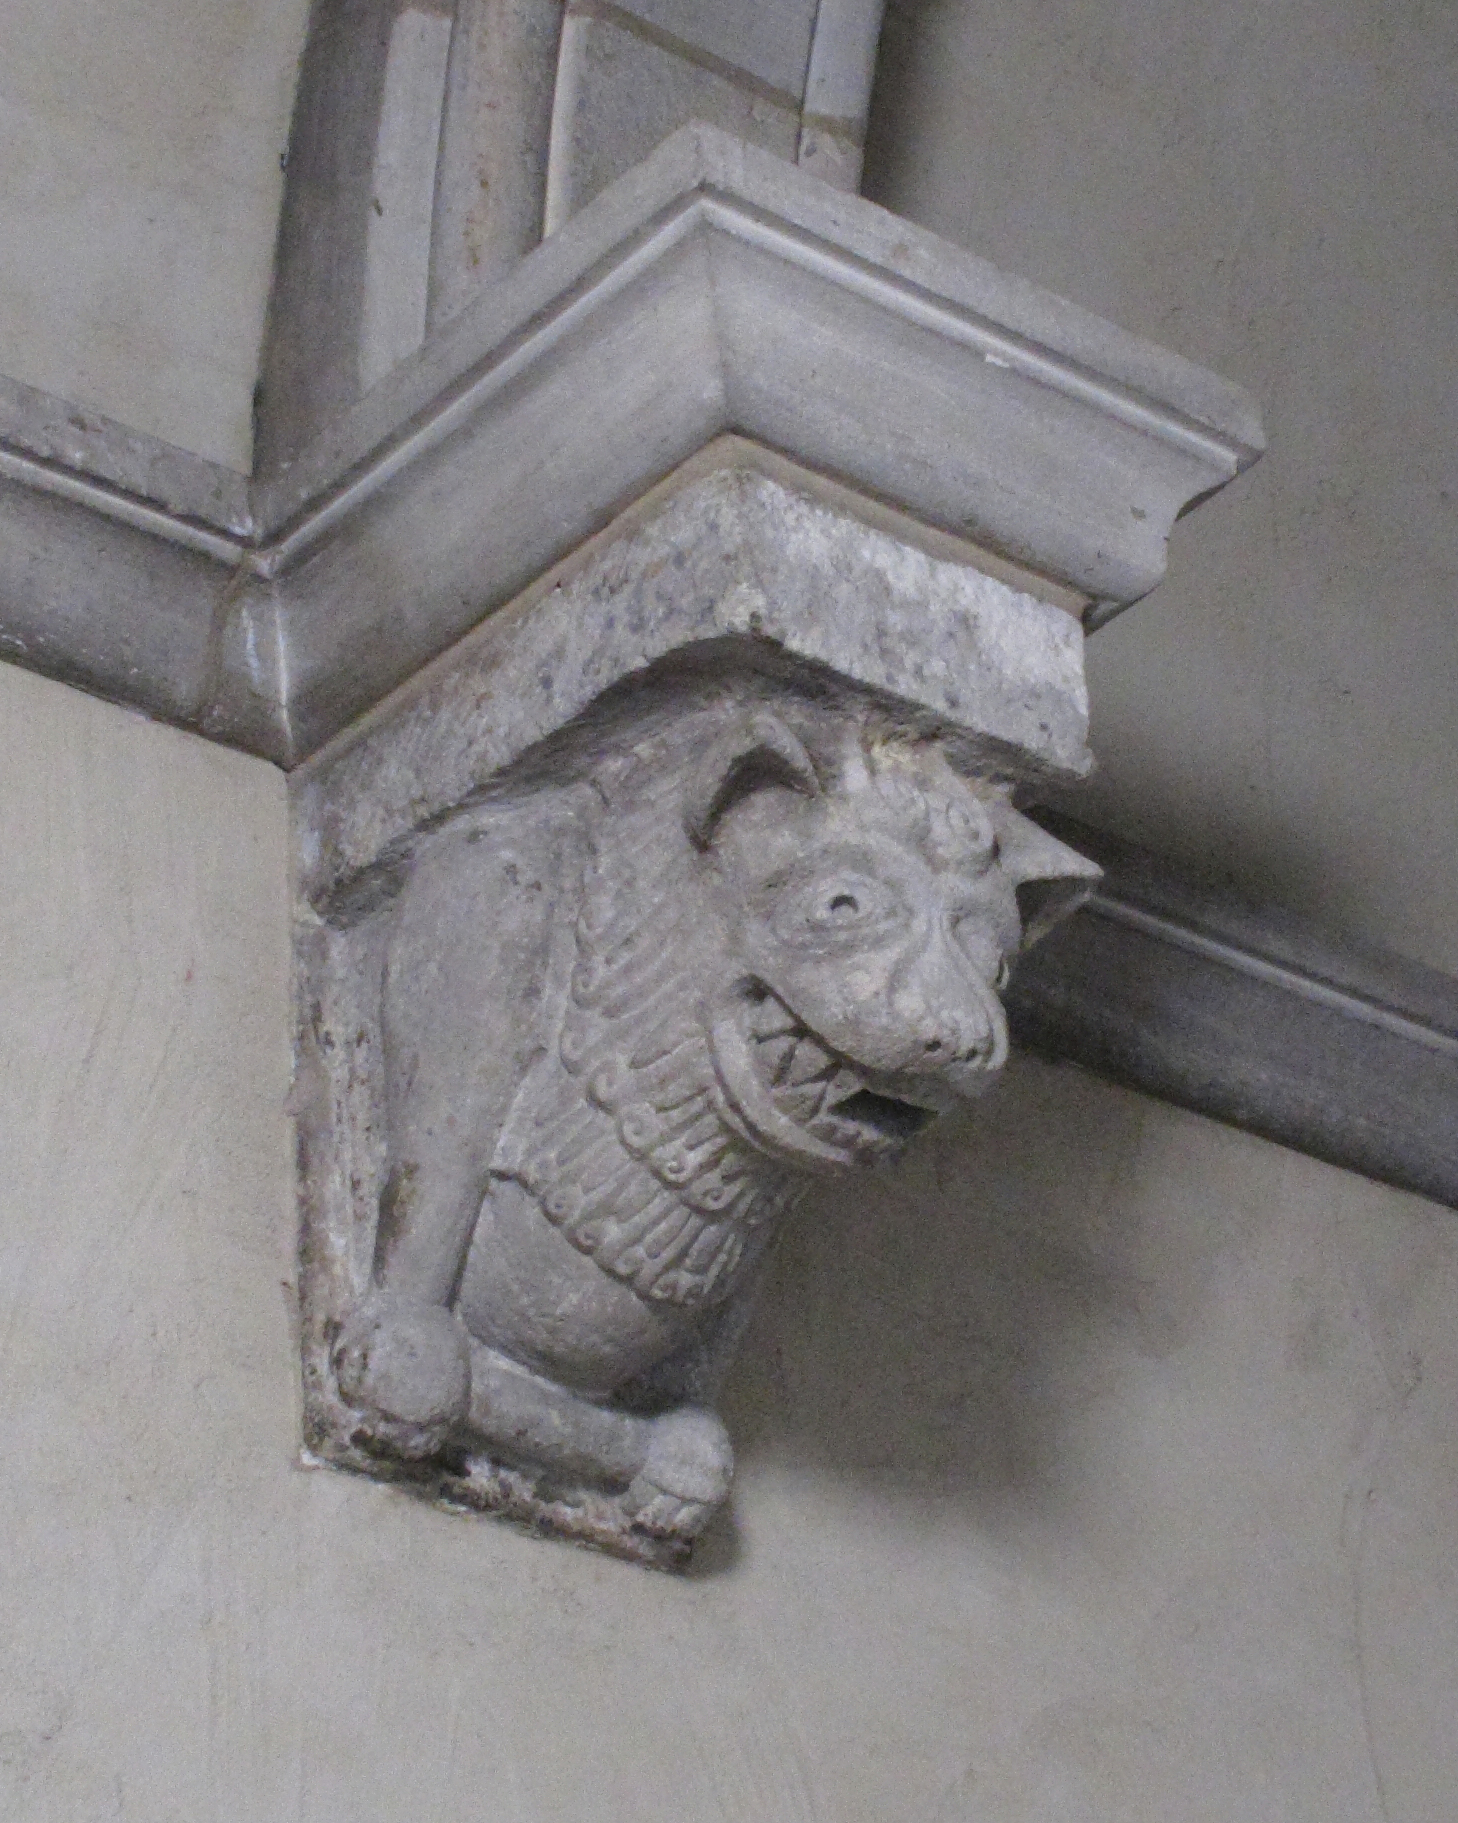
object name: corbel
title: Corbel with Fore Portion of Beast with Bone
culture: french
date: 1150-1200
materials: limestone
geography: france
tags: animals